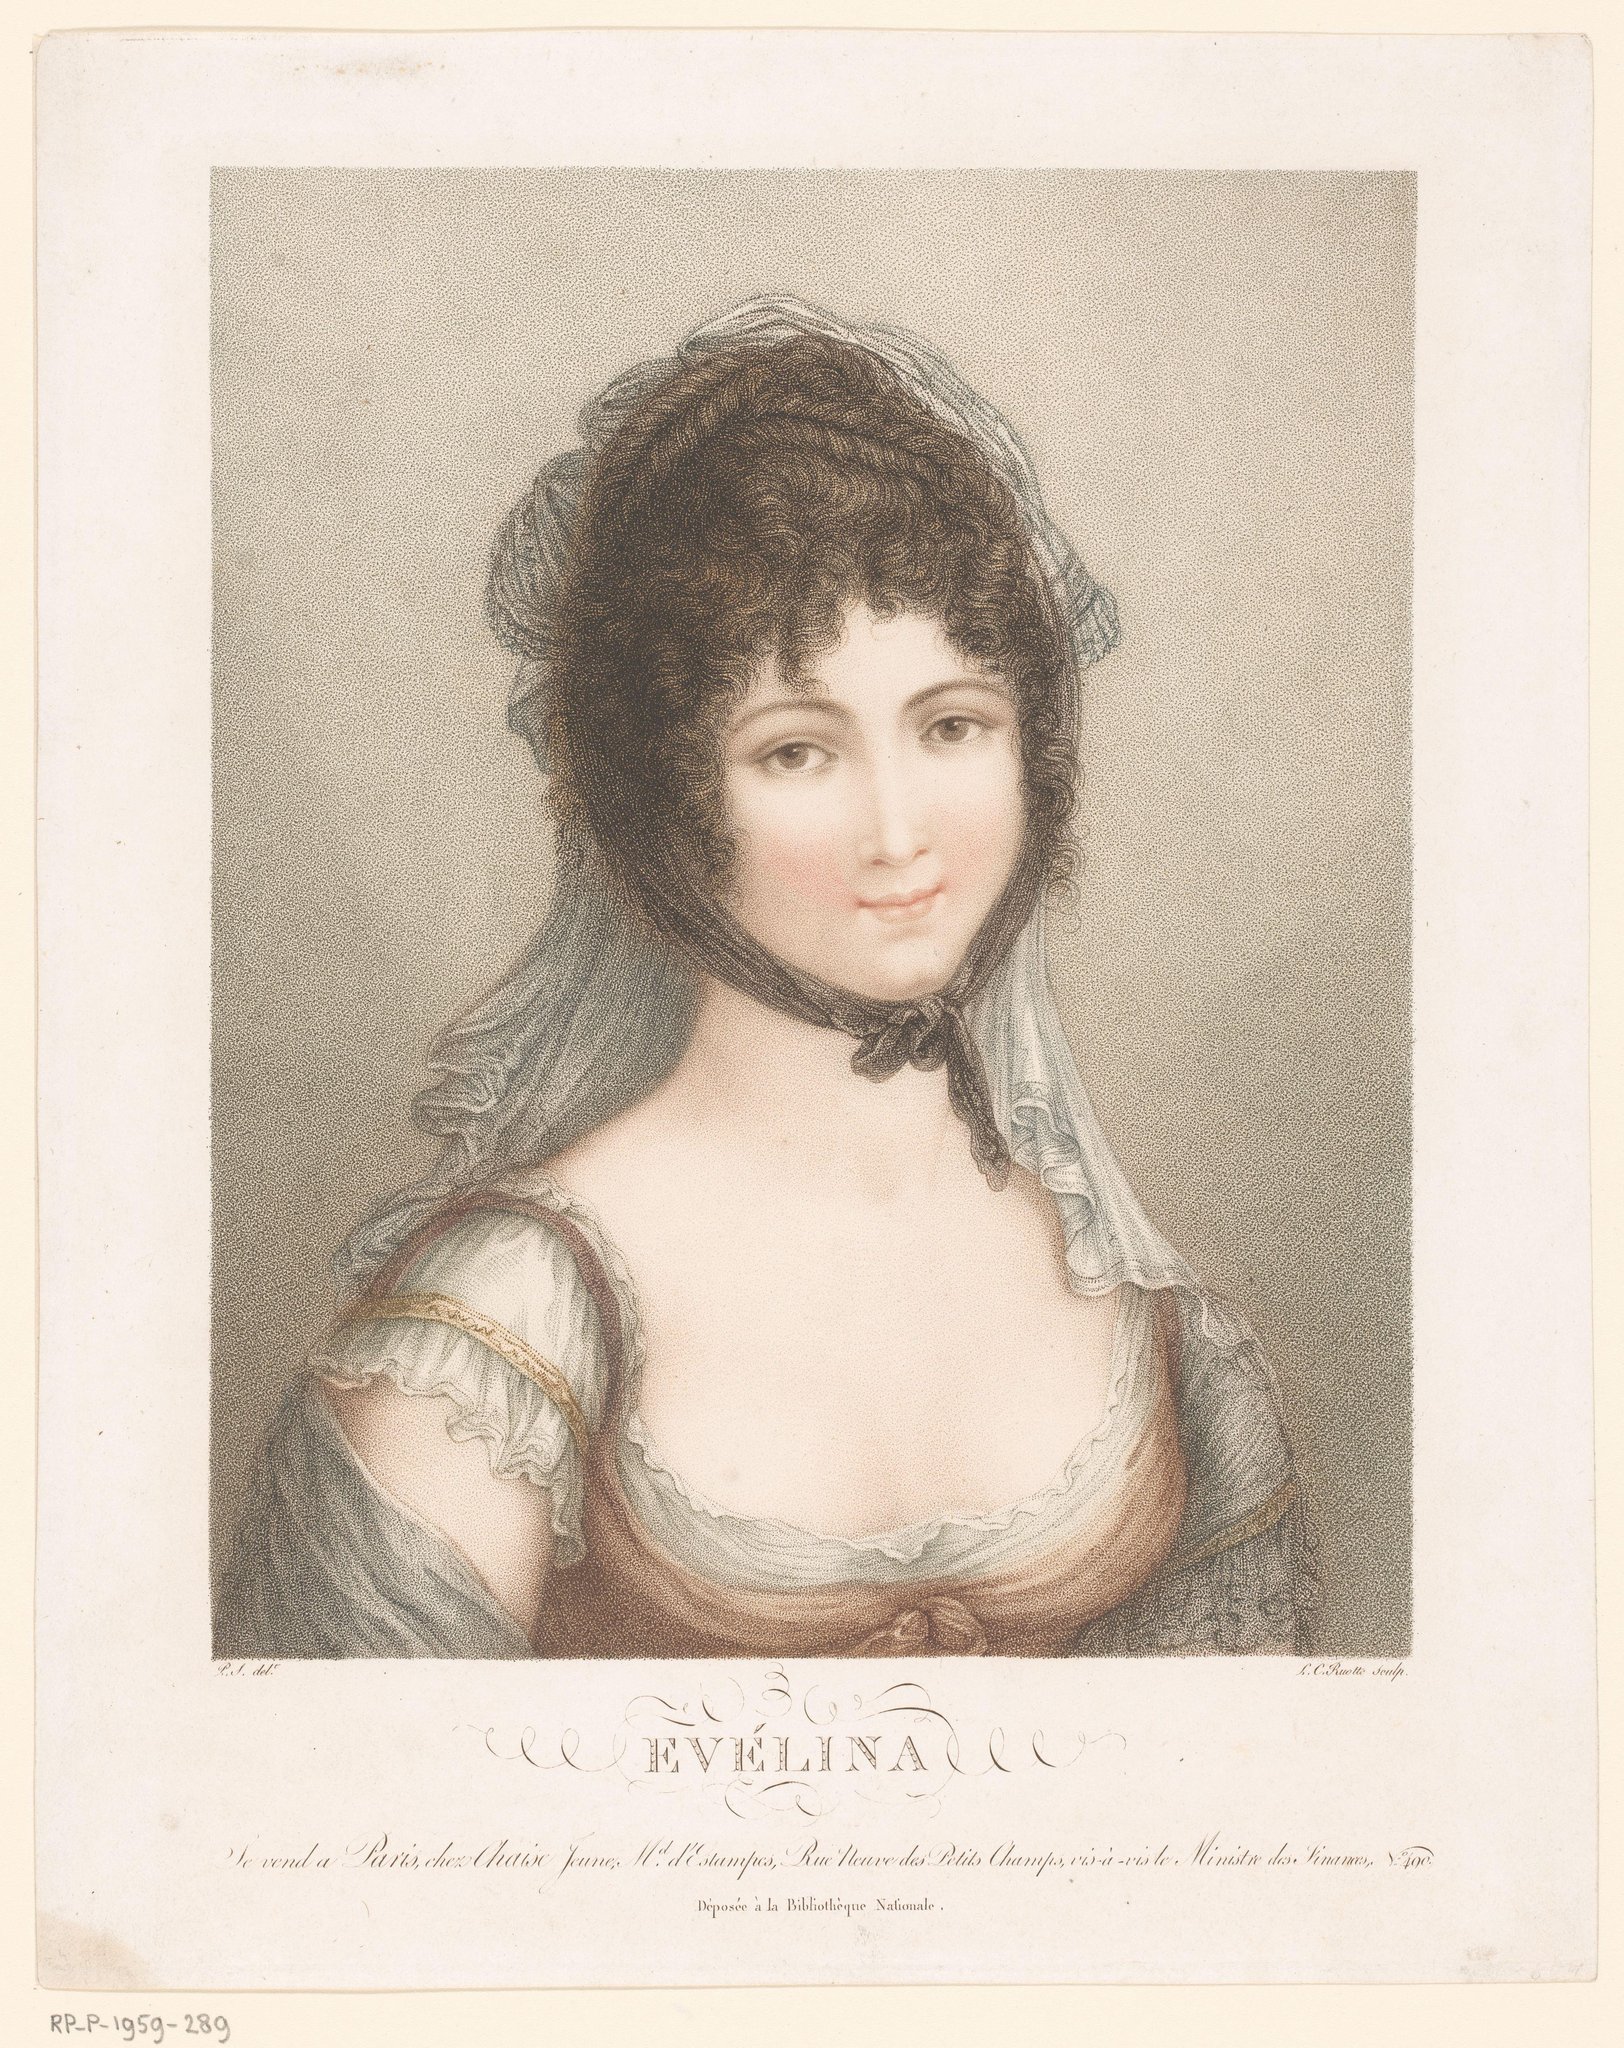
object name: print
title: Evélina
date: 1800-1806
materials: paper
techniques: etching, lithography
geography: paris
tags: adult woman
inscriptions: collector's mark: Lugt 2228, collector's mark: Lugt 2760, : ‘Déposé à la Bibliothèque Nationale’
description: Buste van vrouw, hoofd leunend naar rechterschouder, doek onder kin vastgeknoopt.